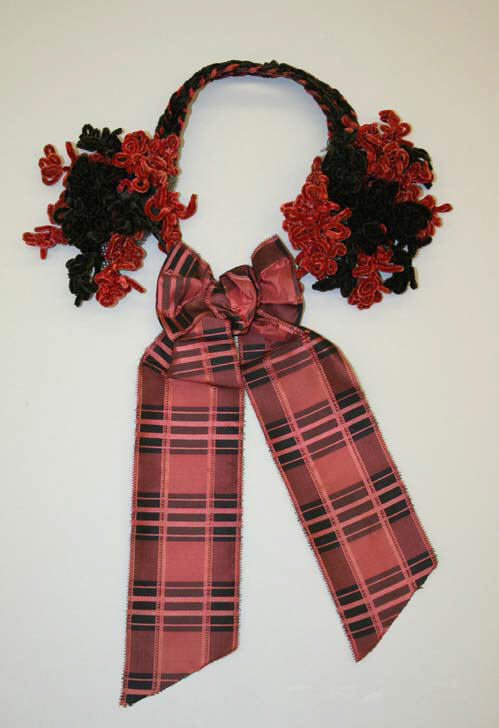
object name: headdress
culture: american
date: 1859-1860